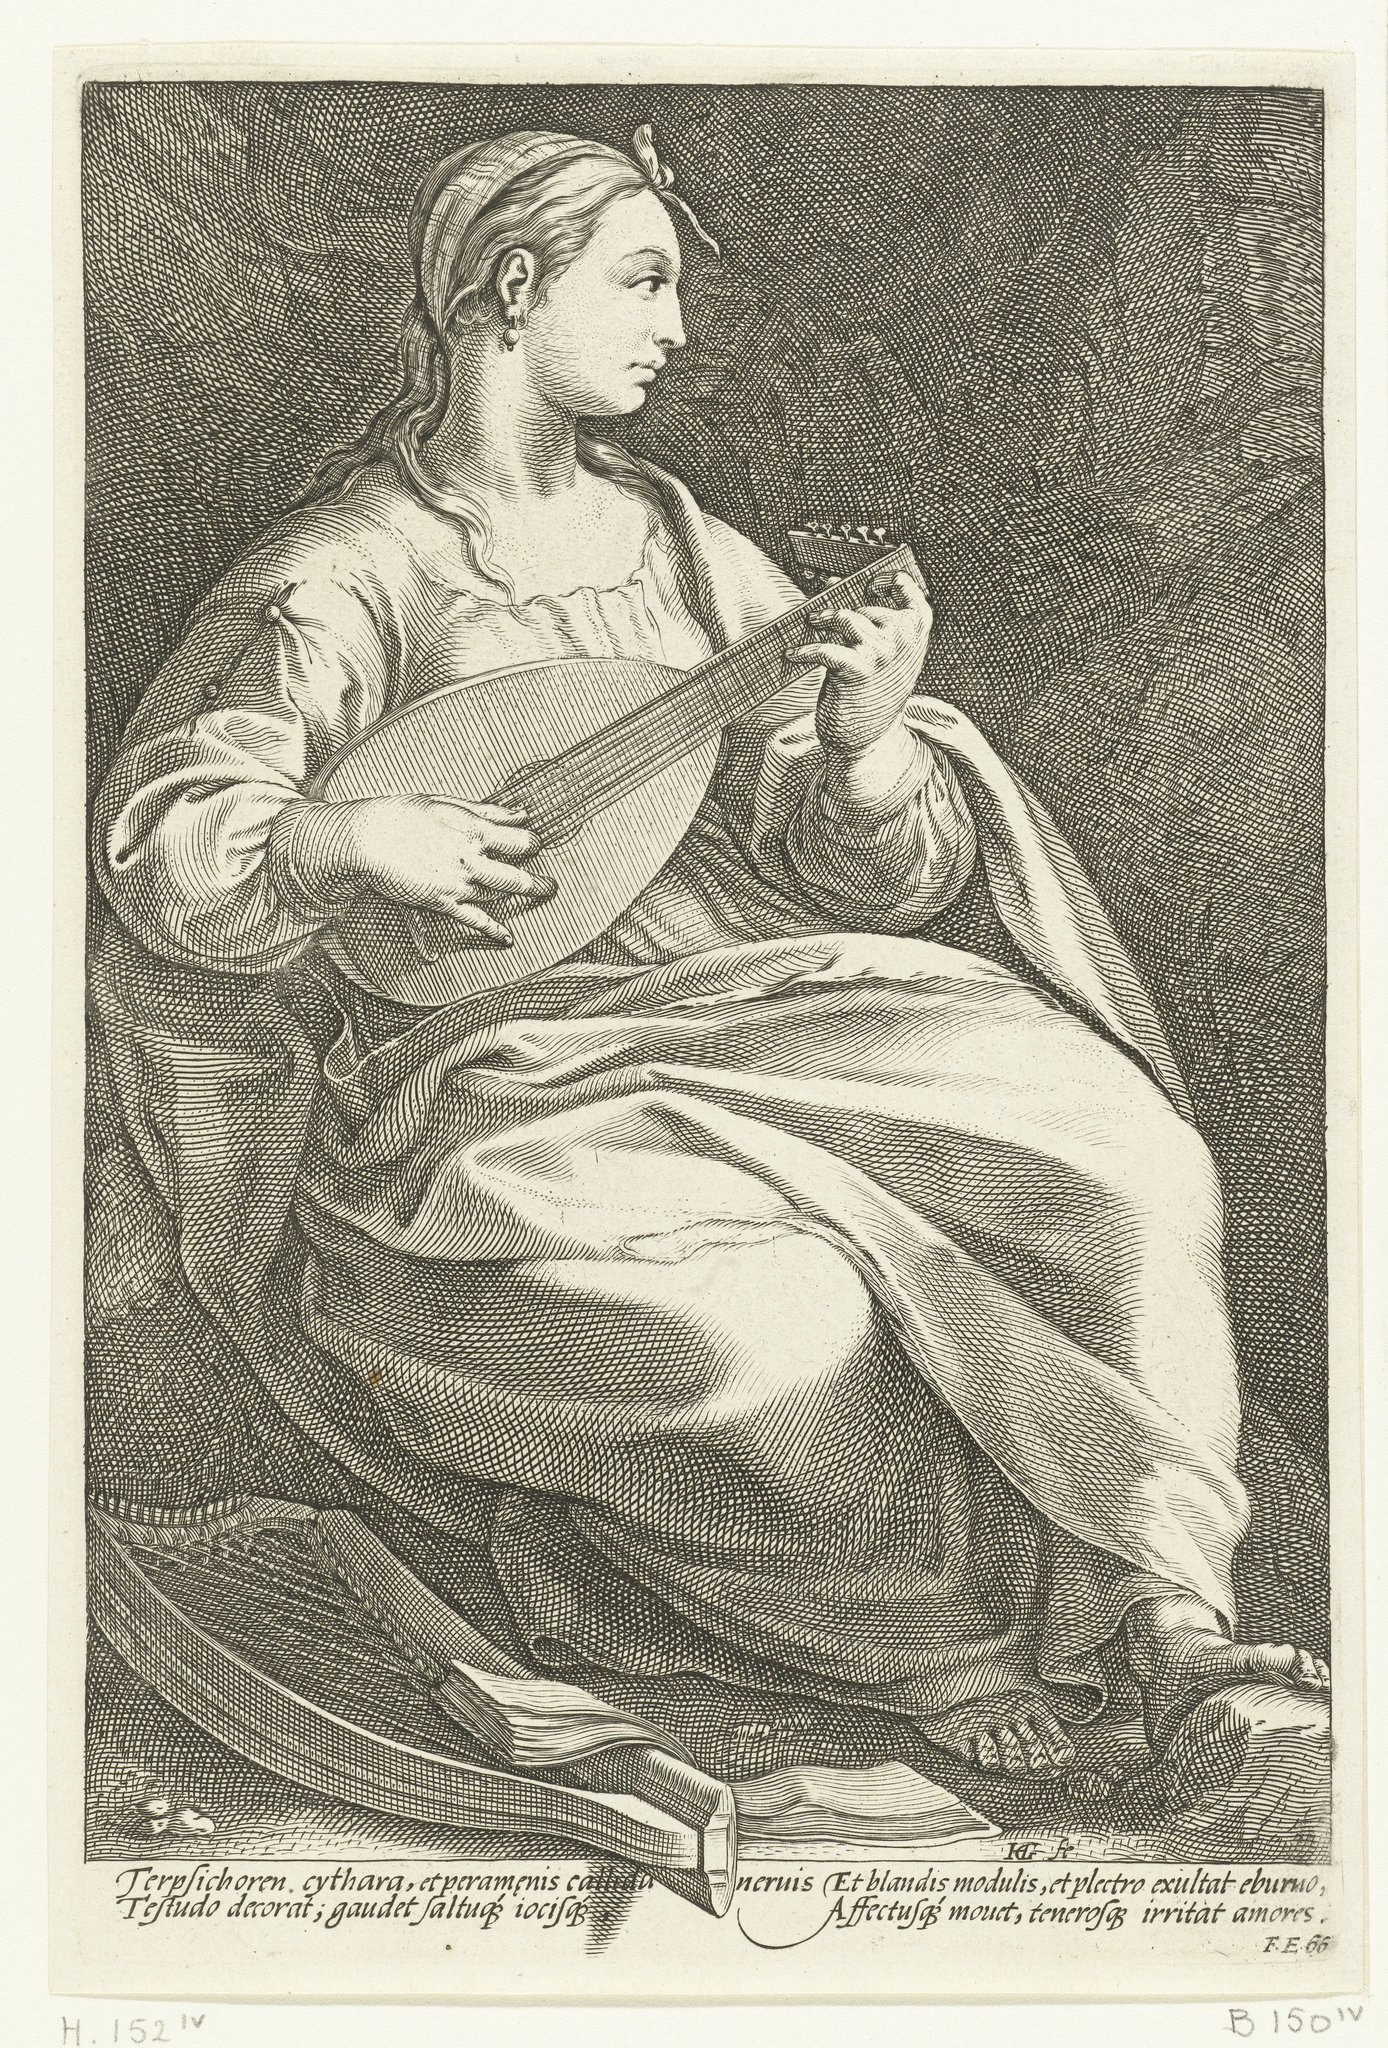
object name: print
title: Terpsichore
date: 1592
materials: paper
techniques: engraving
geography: haarlem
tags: terpsichore (one of the muses); 'terpsicore' (ripa)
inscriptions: signature: ‘F.E.’, collector's mark: Lugt 2228a, signature: ‘HG fe’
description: Een serie van negen muzen. Vier regels Latijn van Franco Estius in marge onder prent.